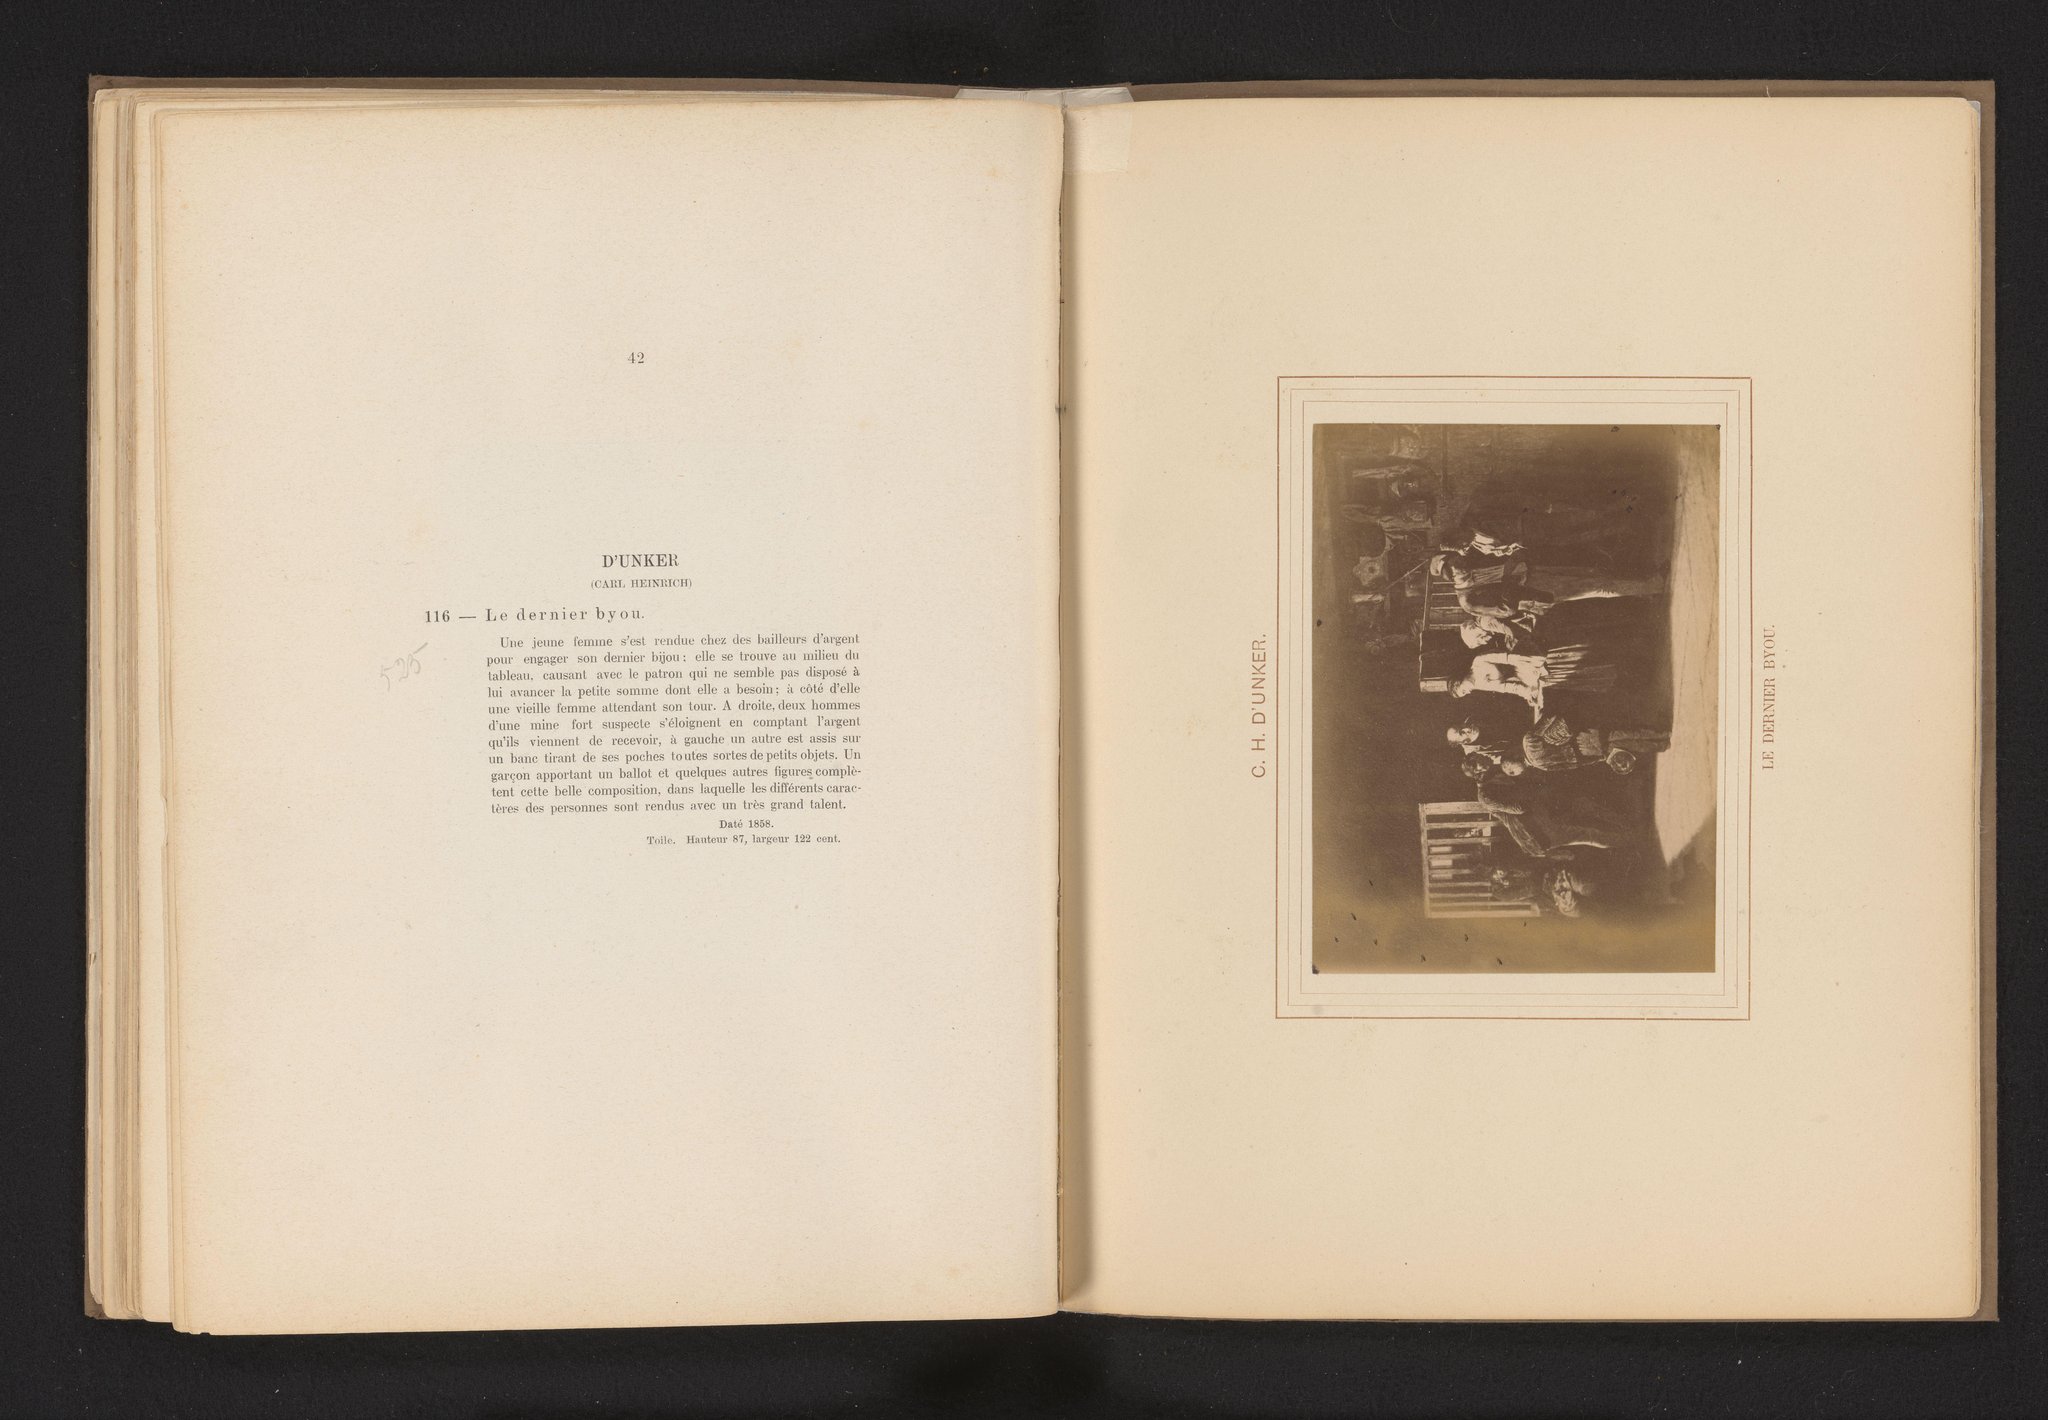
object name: photograph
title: Fotoreproductie van Le dernier byou door Carl Henrik D'Unker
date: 1878-1883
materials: paper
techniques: albumen print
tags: painting, drawing and the graphic arts